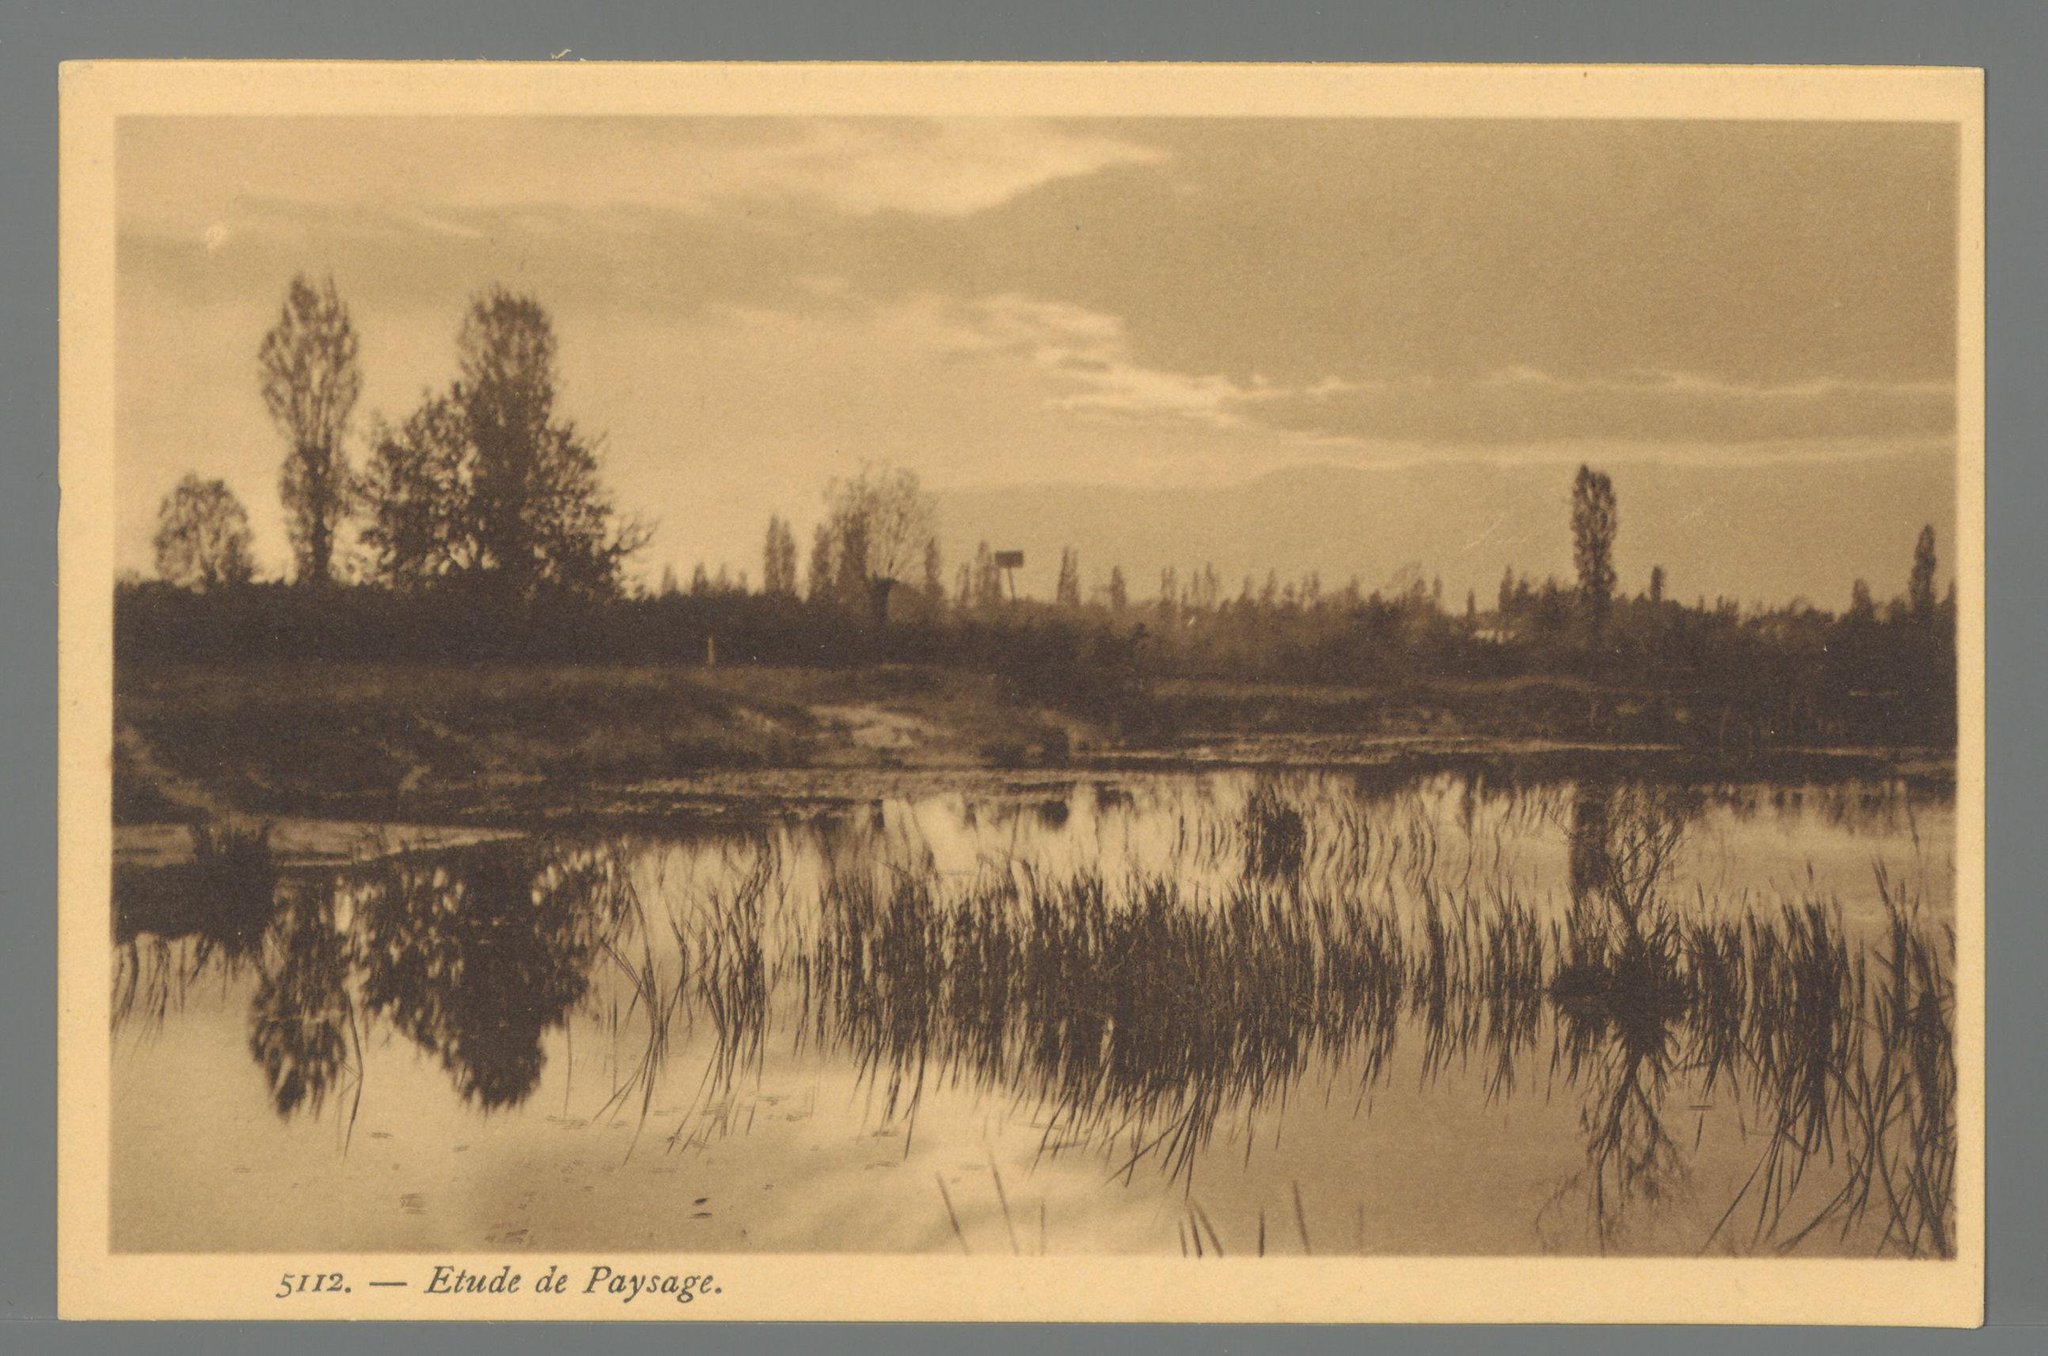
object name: photomechanical print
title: Etude de Paysage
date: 1905-1909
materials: cardboard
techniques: photograph, writing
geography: geneva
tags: trees, landscapes in the temperate zone, switzerland